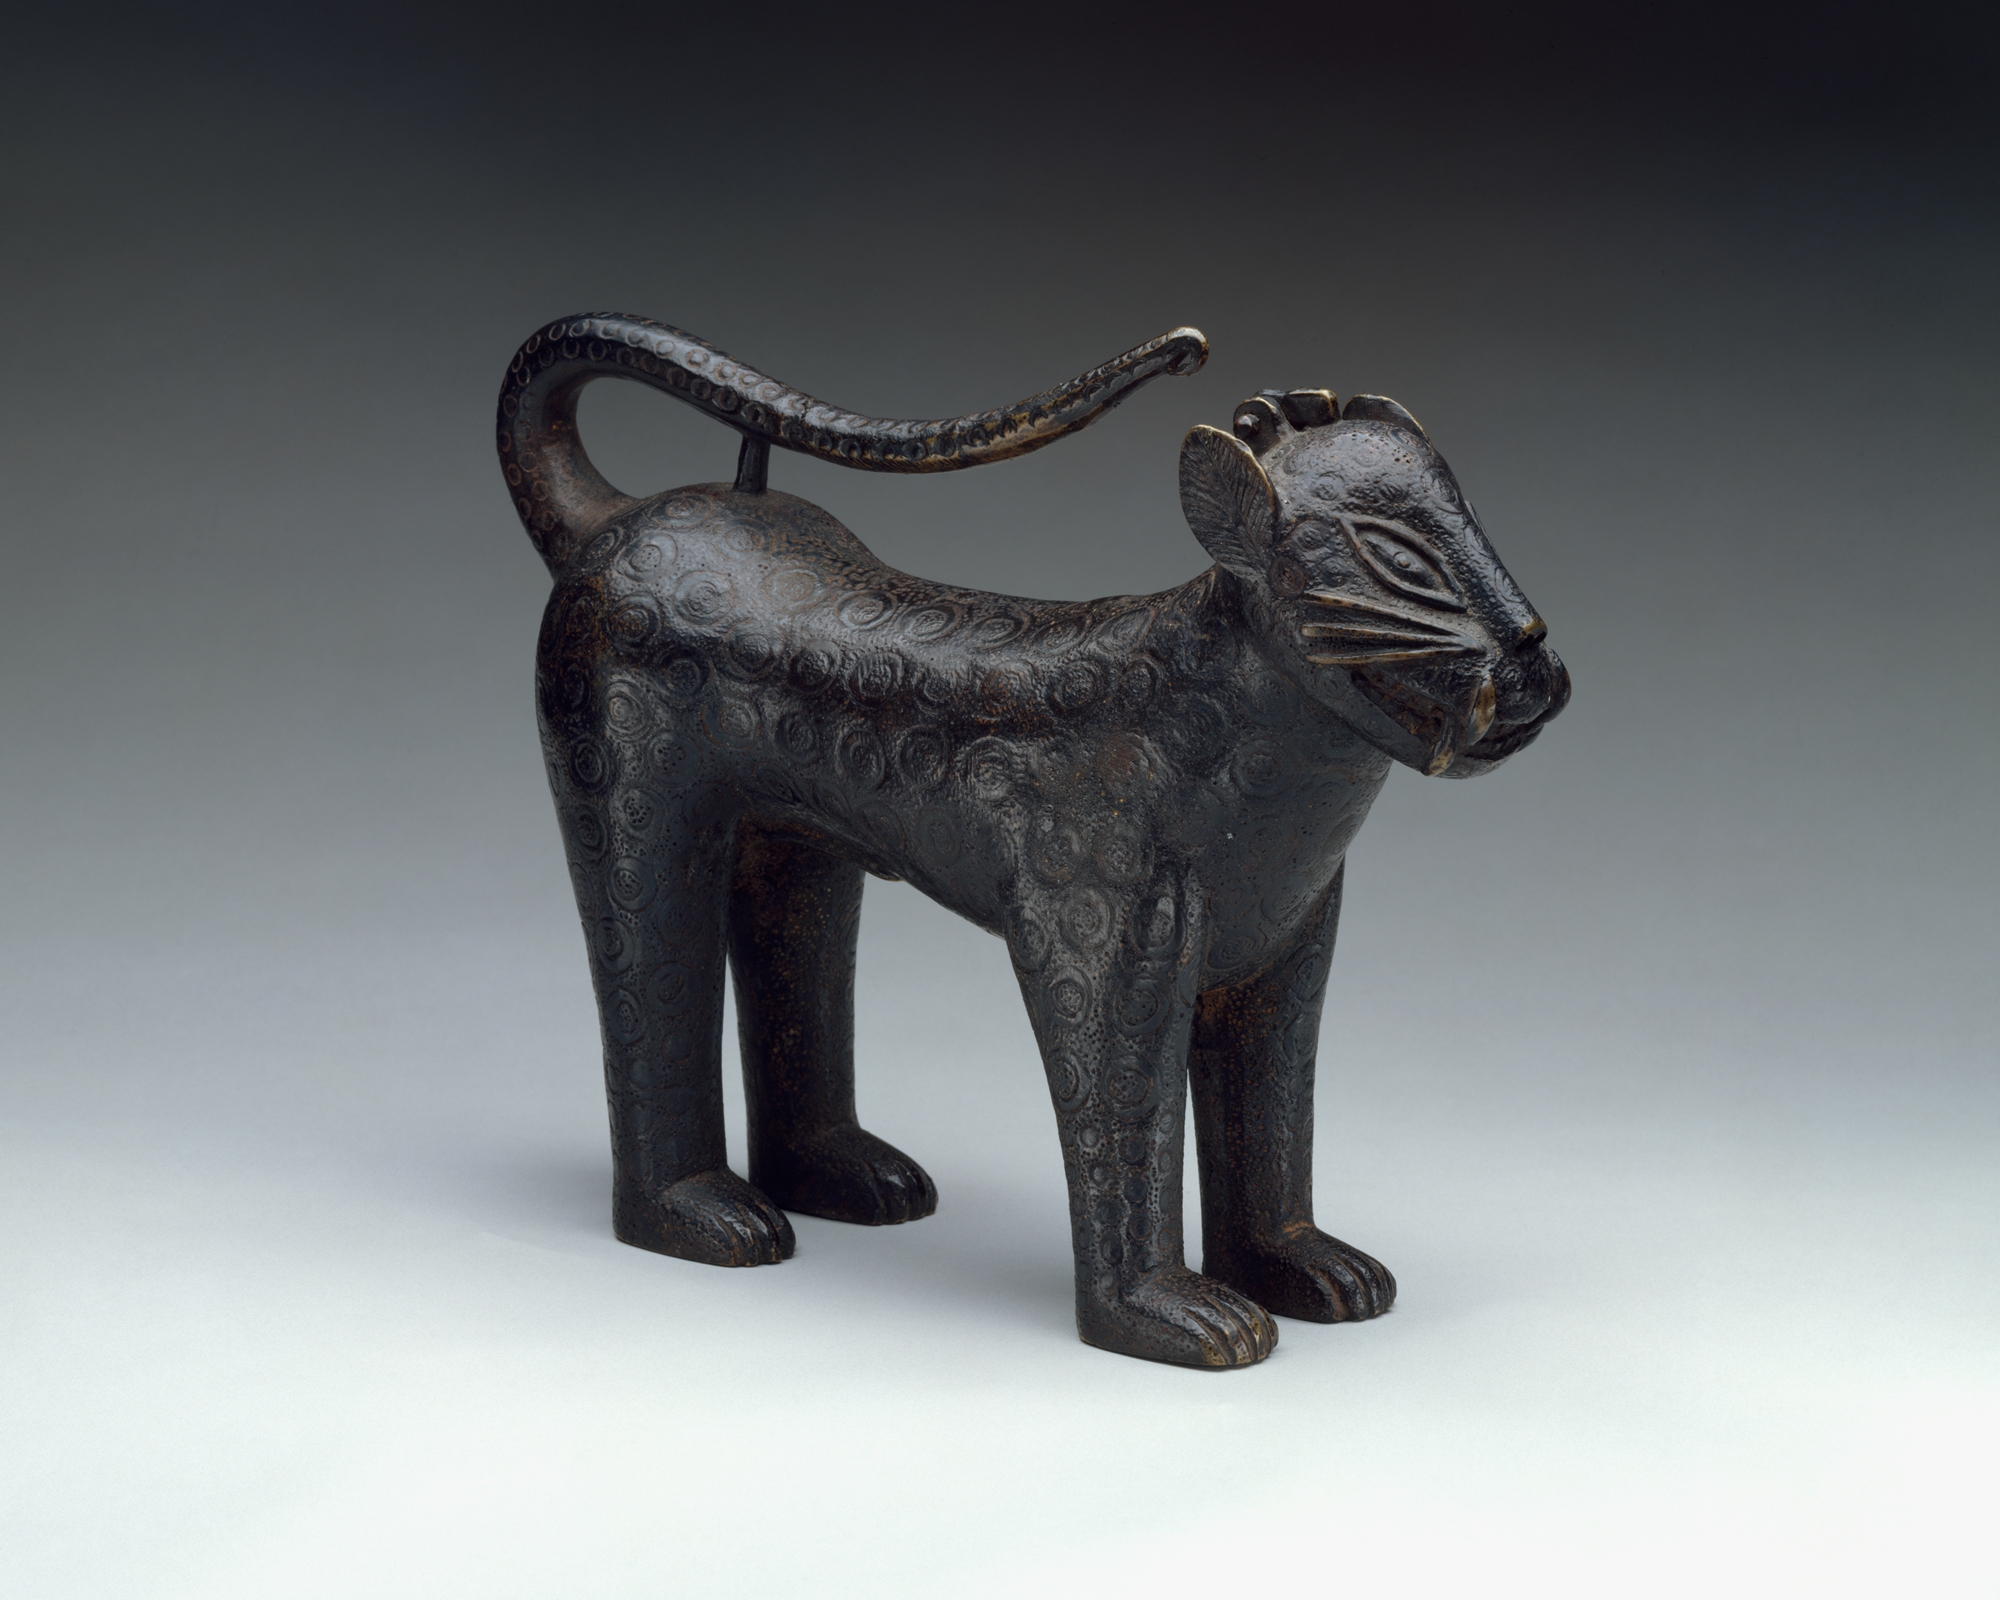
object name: aquamanile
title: Leopard Aquamanile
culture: edo period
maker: edo artist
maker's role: artist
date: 1501-1900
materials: brass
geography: nigeria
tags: leopards